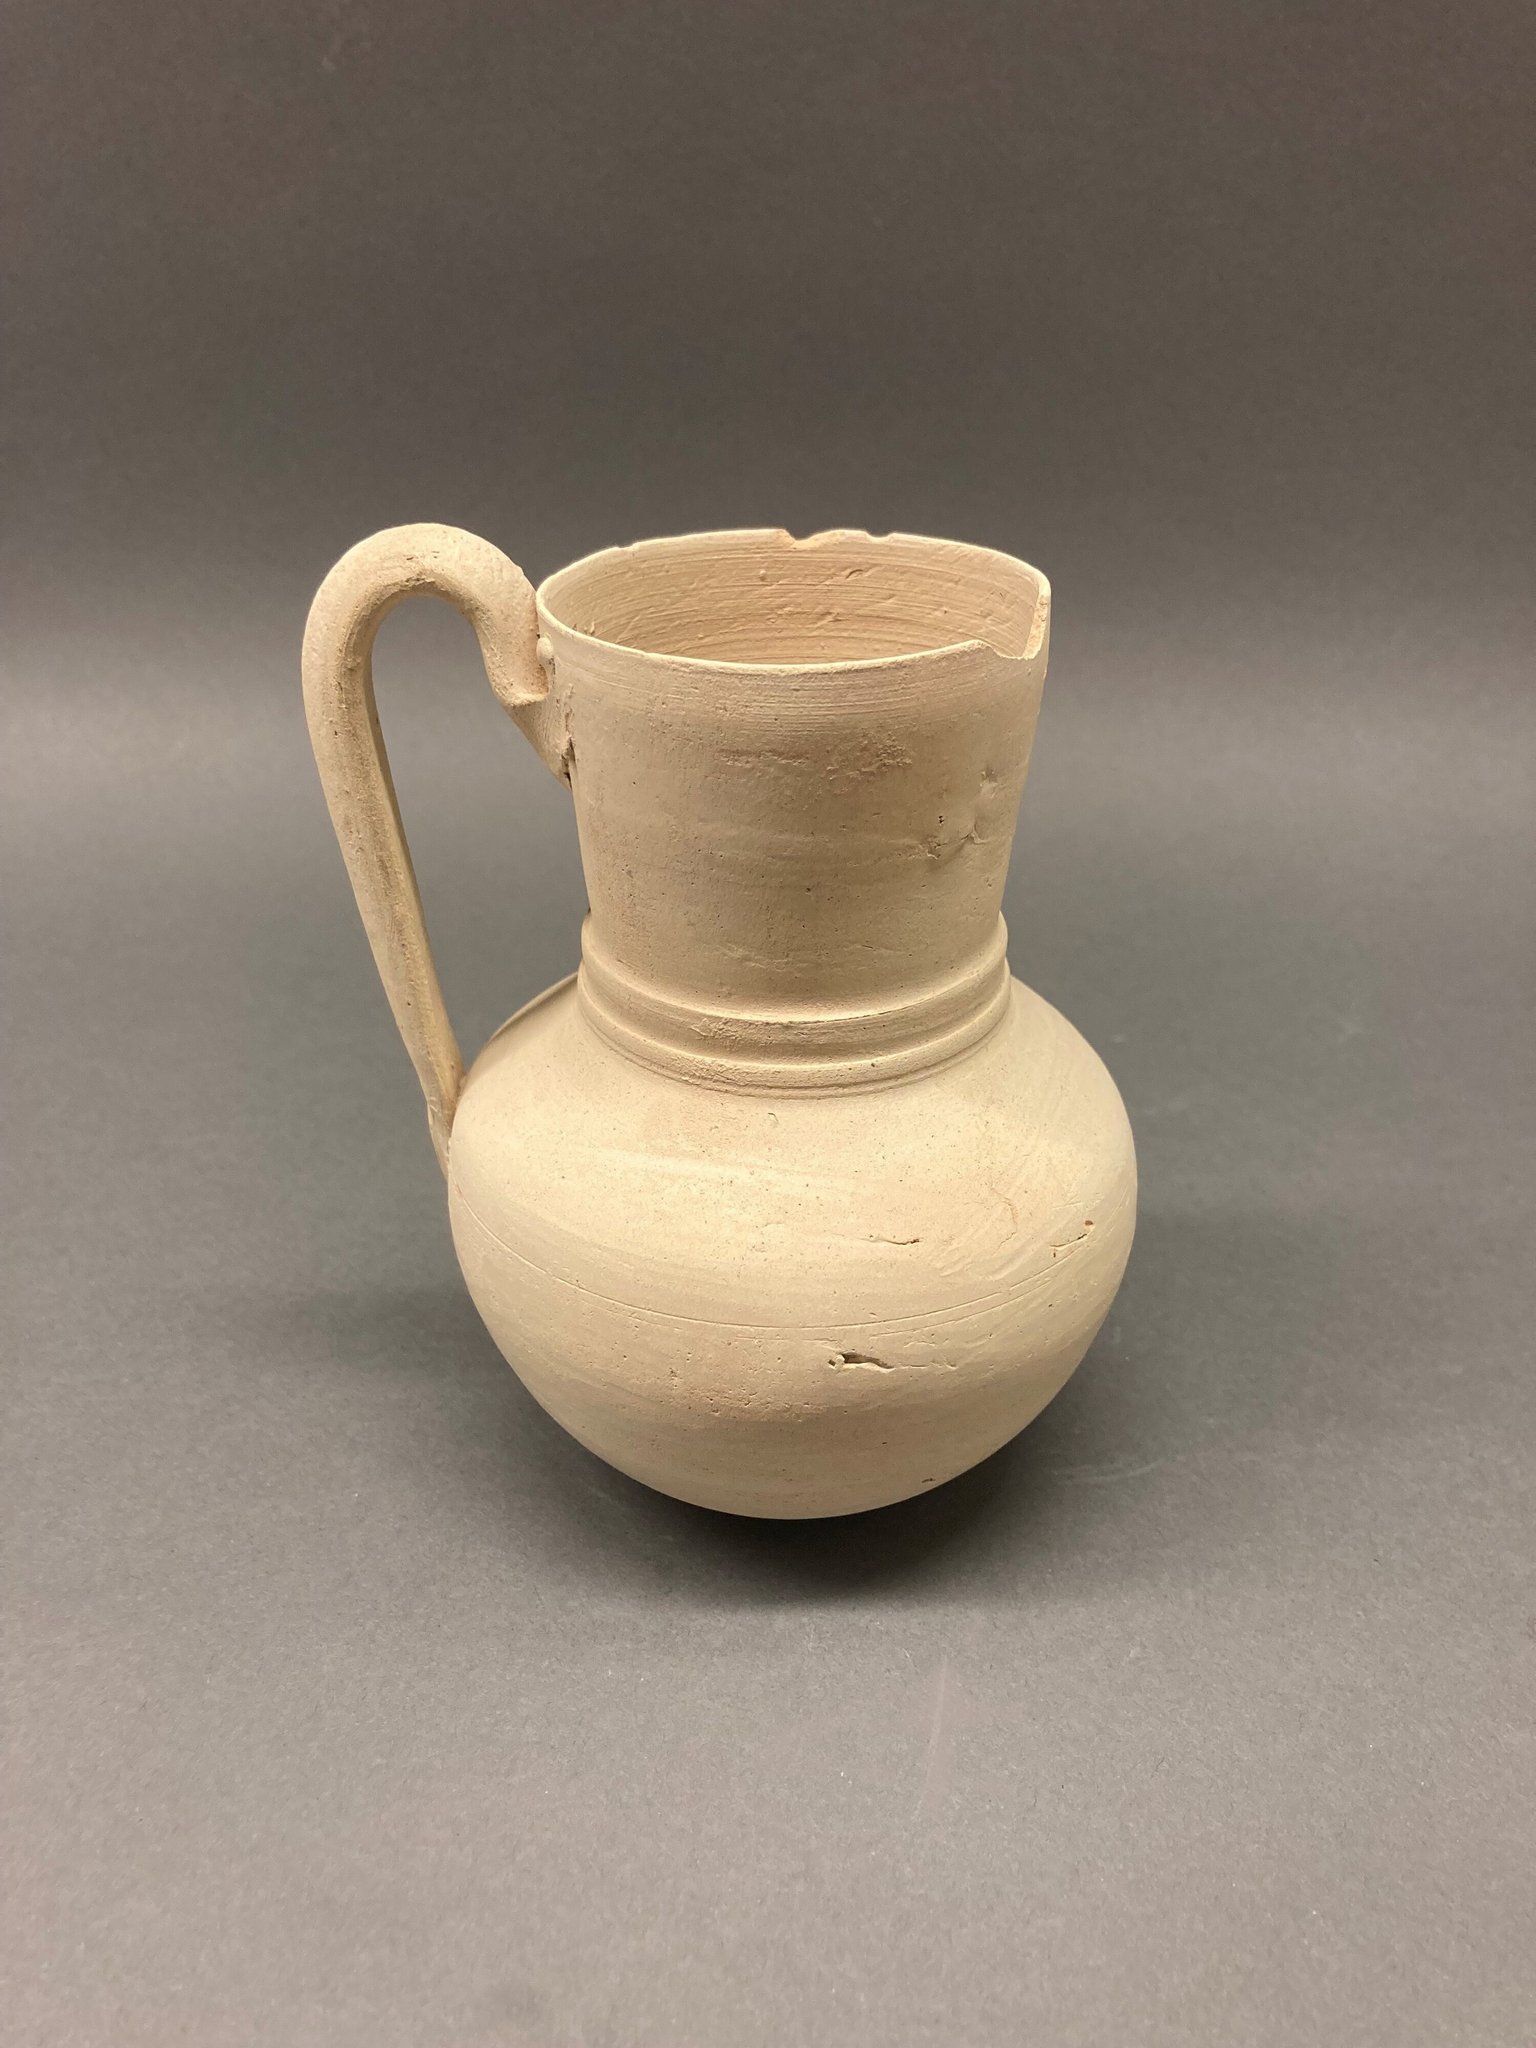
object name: ewer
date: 801-900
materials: earthenware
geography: iran